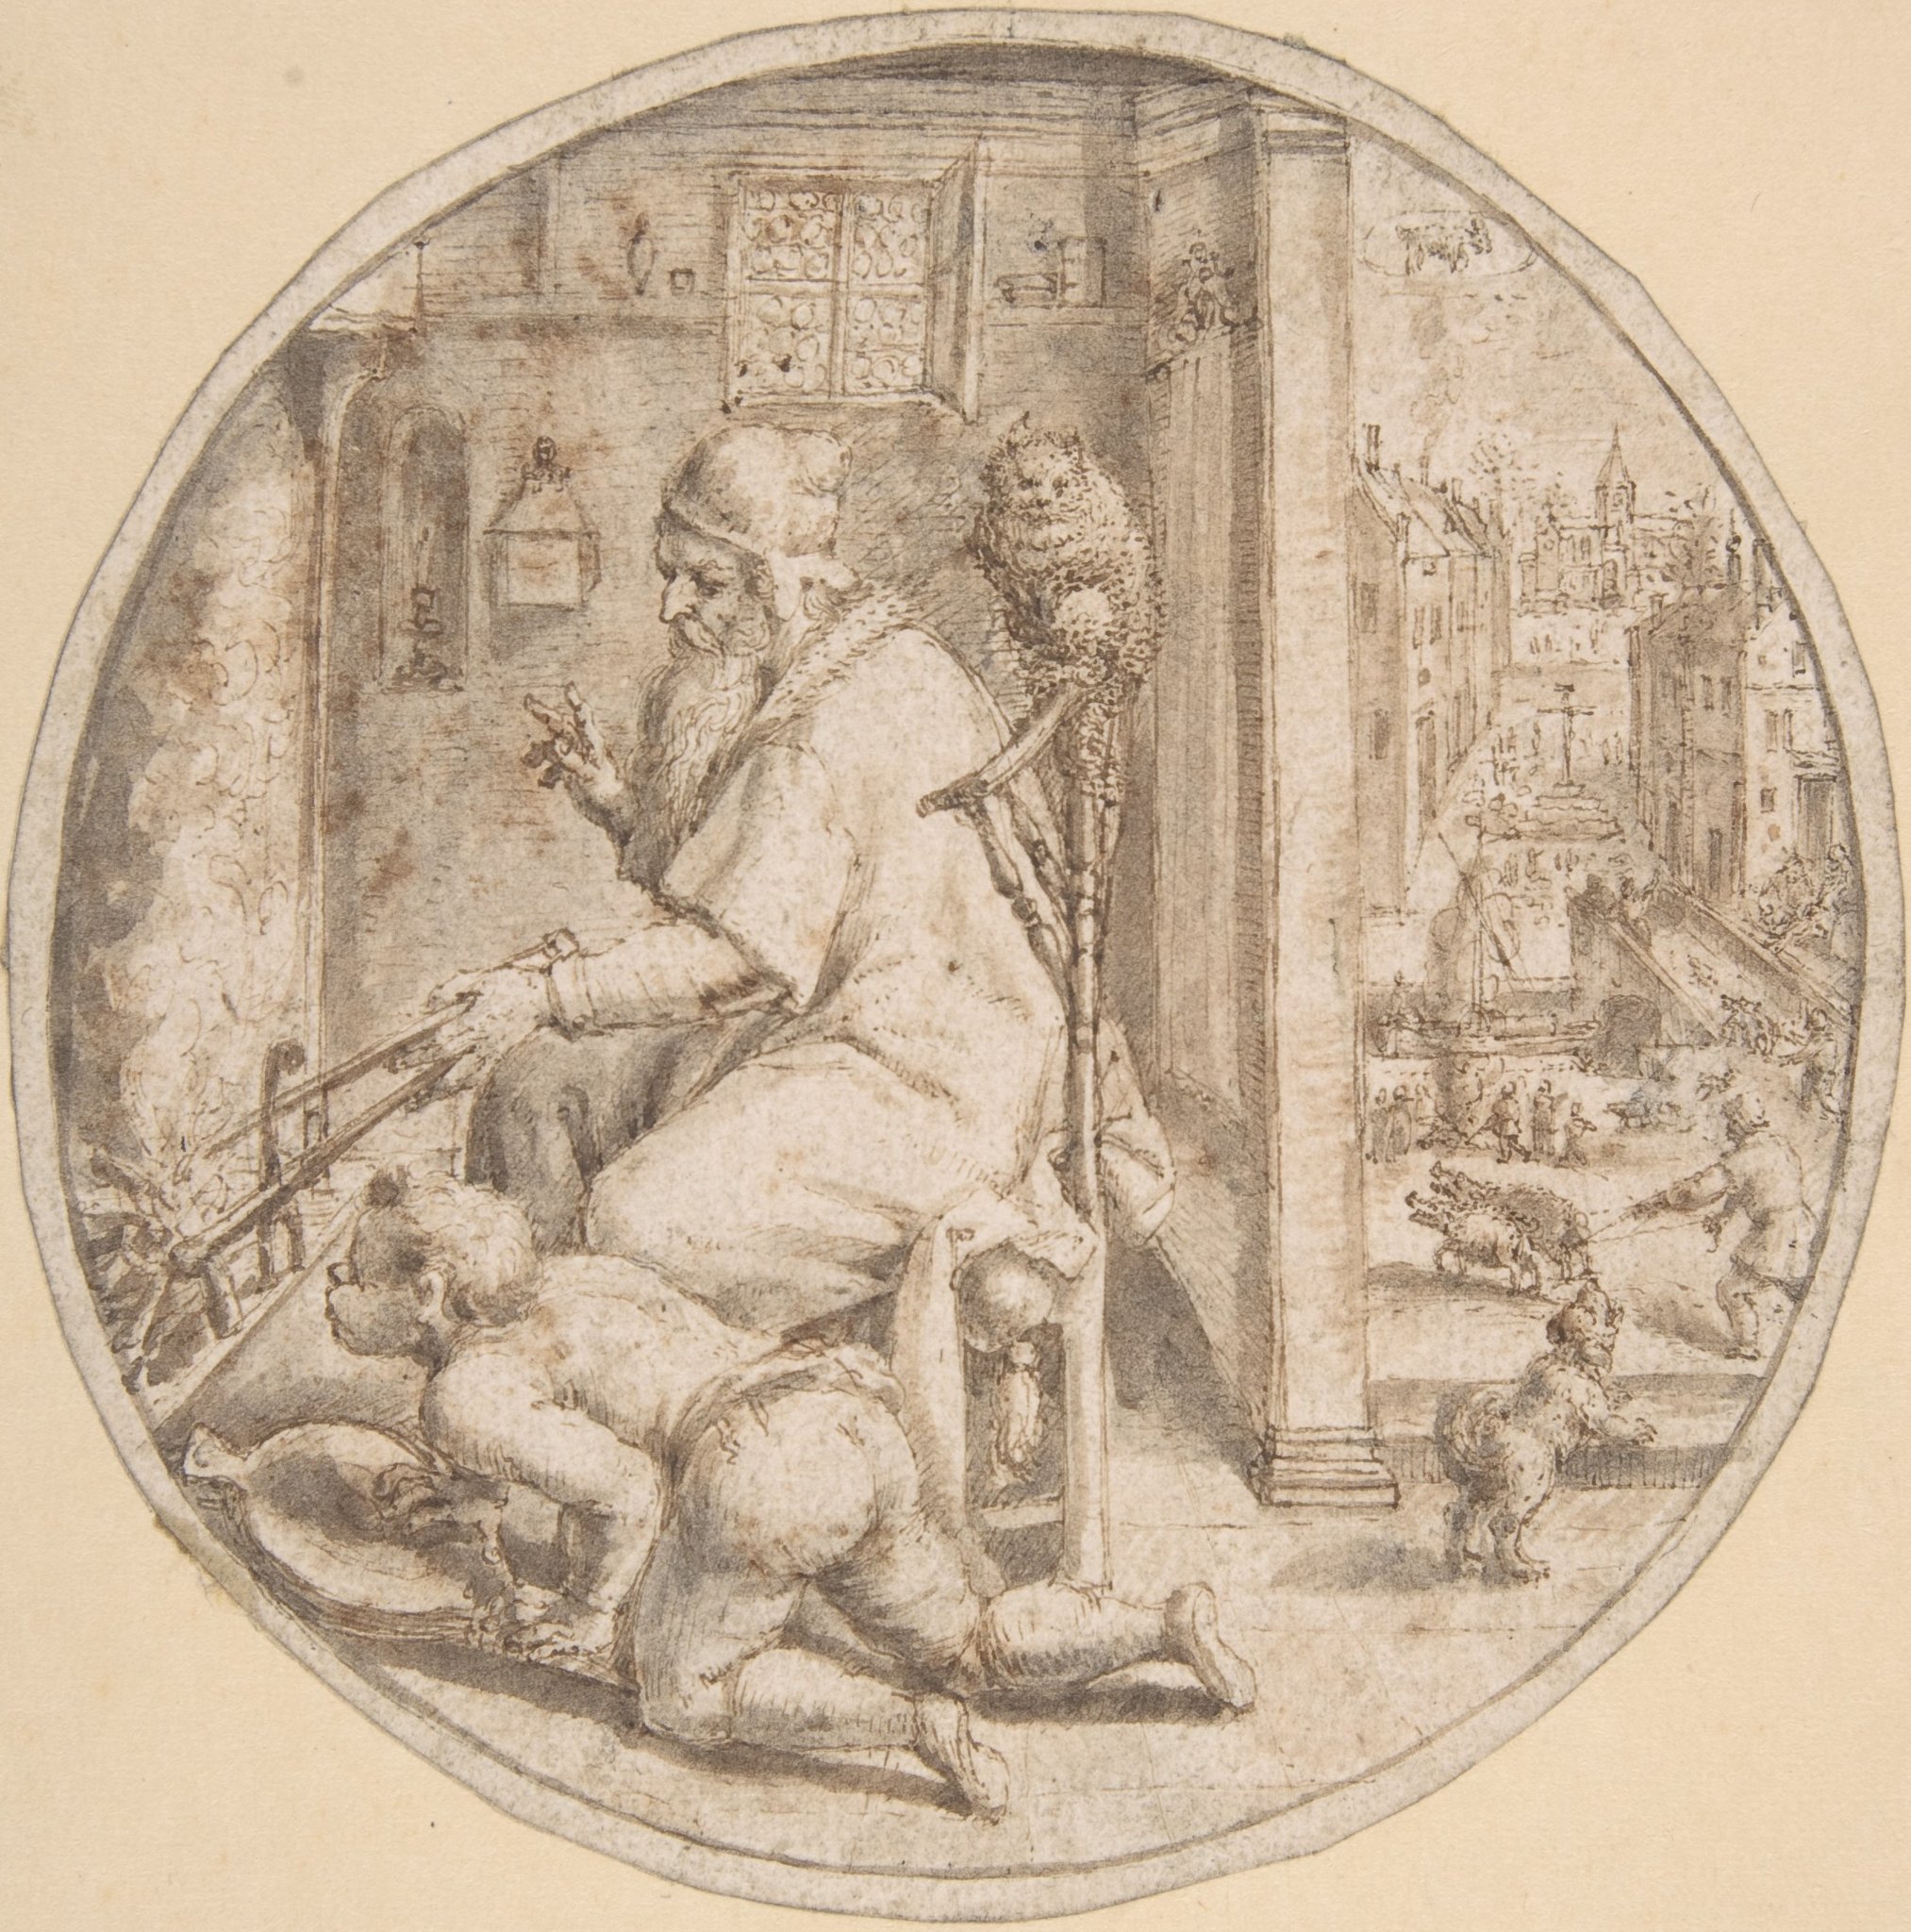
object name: drawing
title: December: And Old Man Seated by a Hearth with a Young Man Blowing on the Fire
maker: crispijn de passe the elder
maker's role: artist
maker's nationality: netherlandish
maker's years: 1564-1637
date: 1567-1666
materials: chalk, ink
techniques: brush, pen, wash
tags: animals,men,fire,working